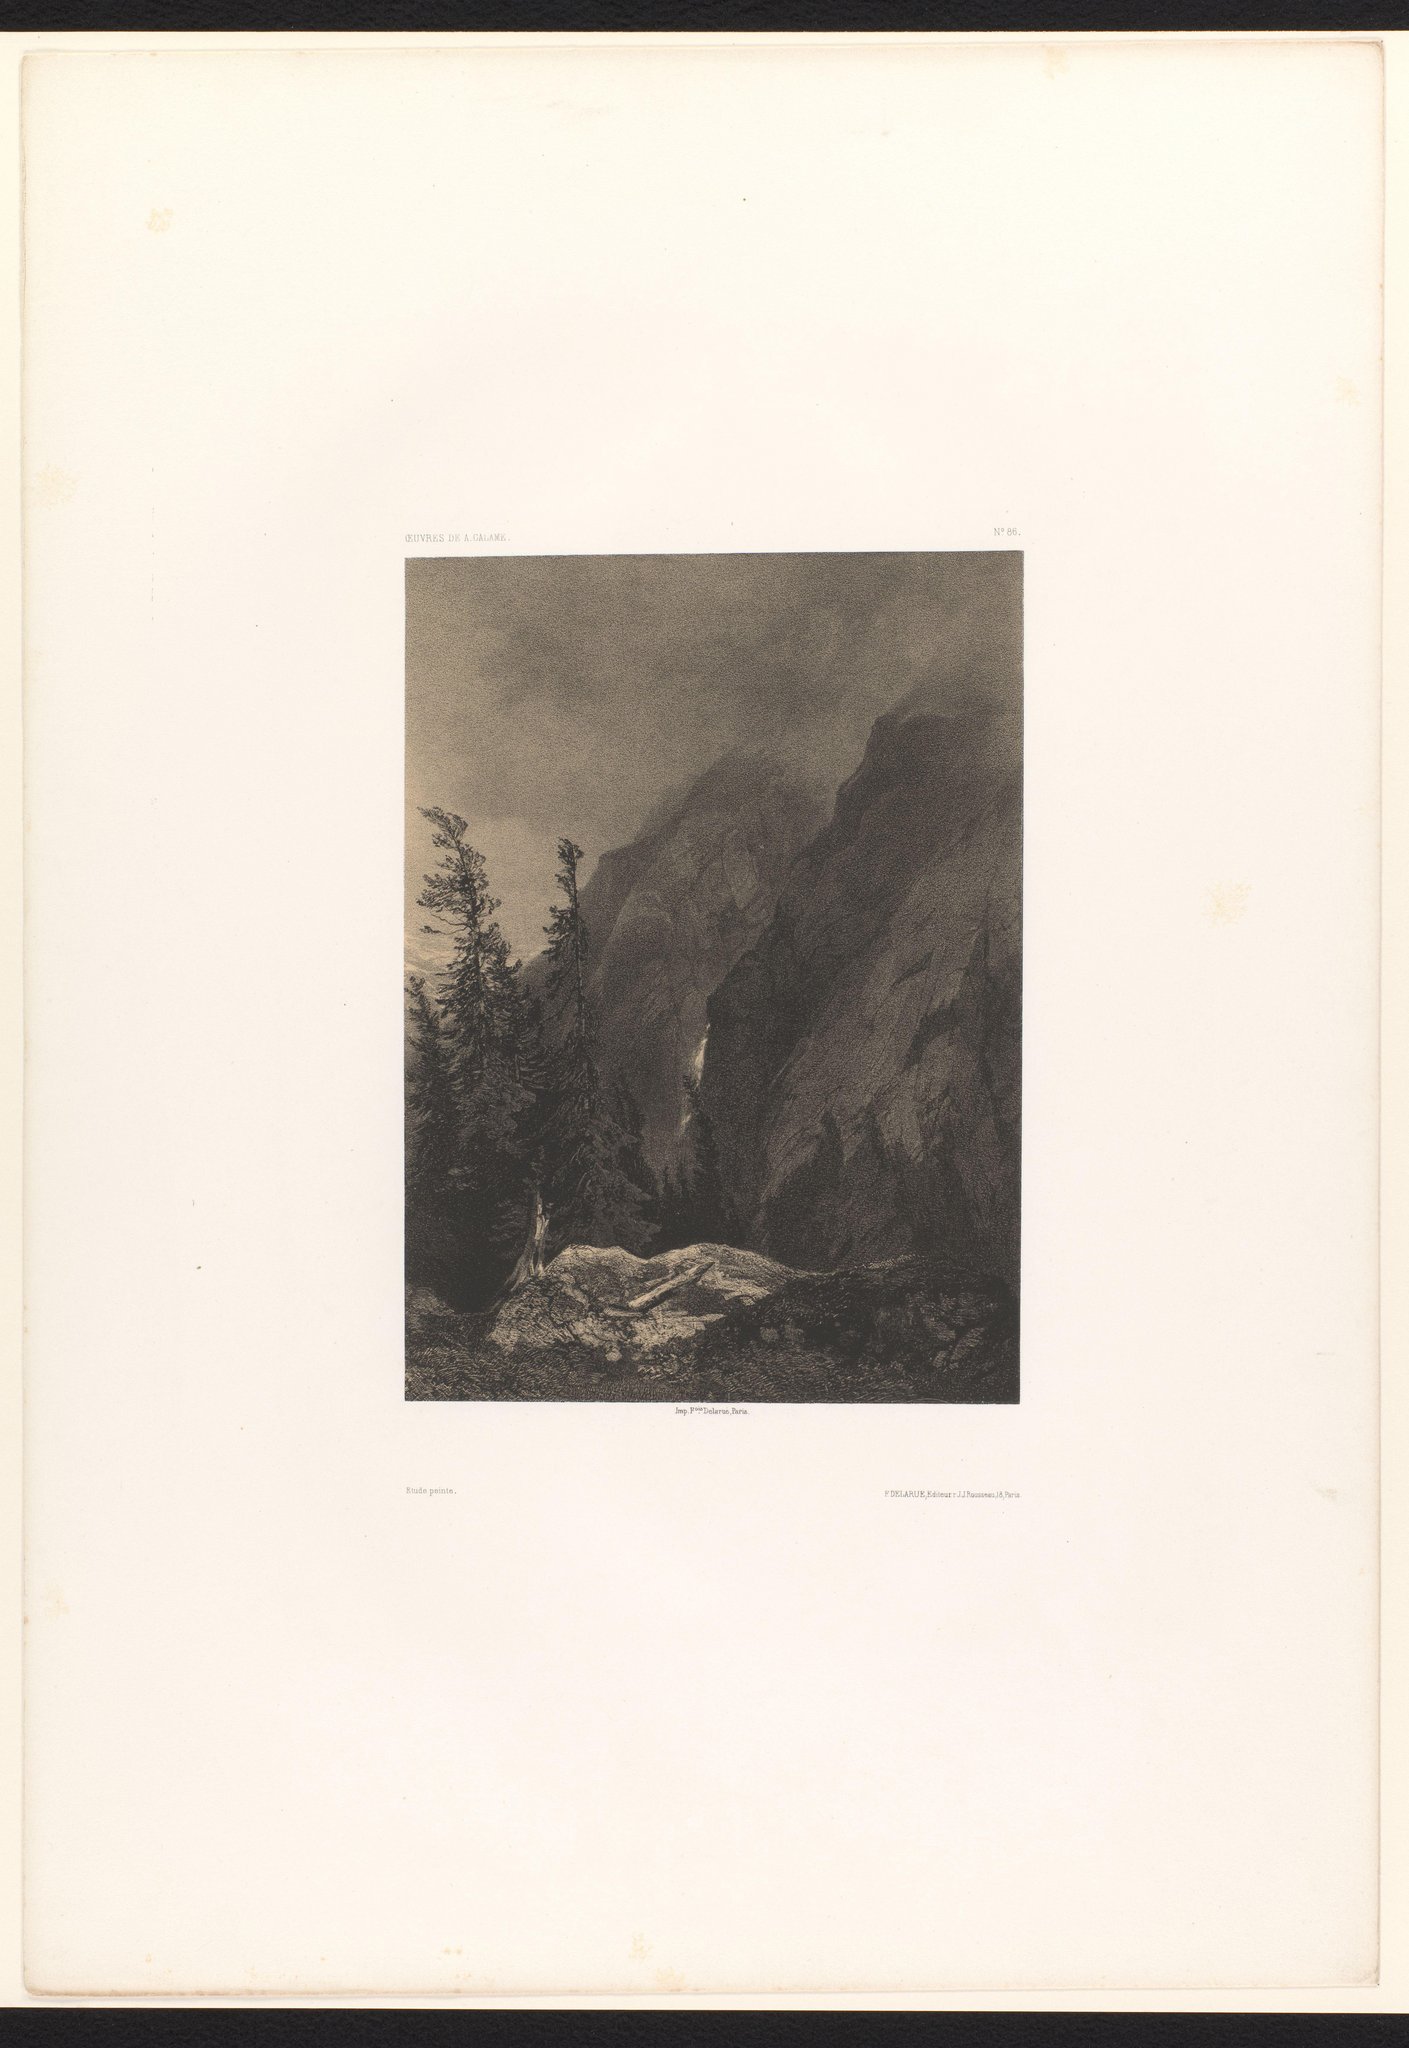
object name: print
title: Oeuvres de A. Calame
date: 1852-1855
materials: paper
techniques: lithograph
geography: paris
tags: trees, waterfall, mountains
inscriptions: collector's mark: Lugt 2228a